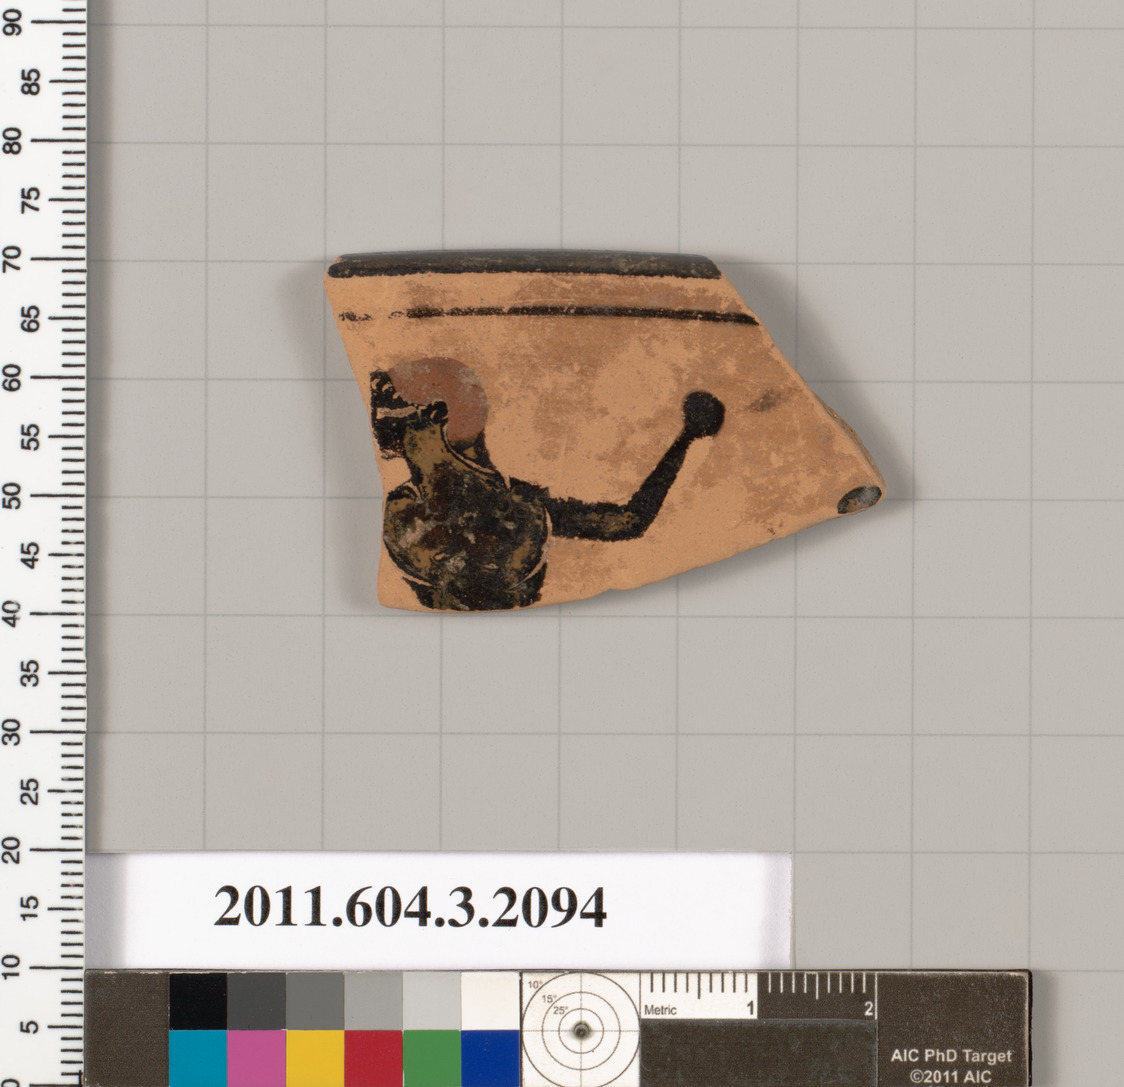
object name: kylix fragment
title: Terracotta rim fragment of a kylix (drinking cup)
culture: greek, attic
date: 534-468 BCE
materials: terracotta